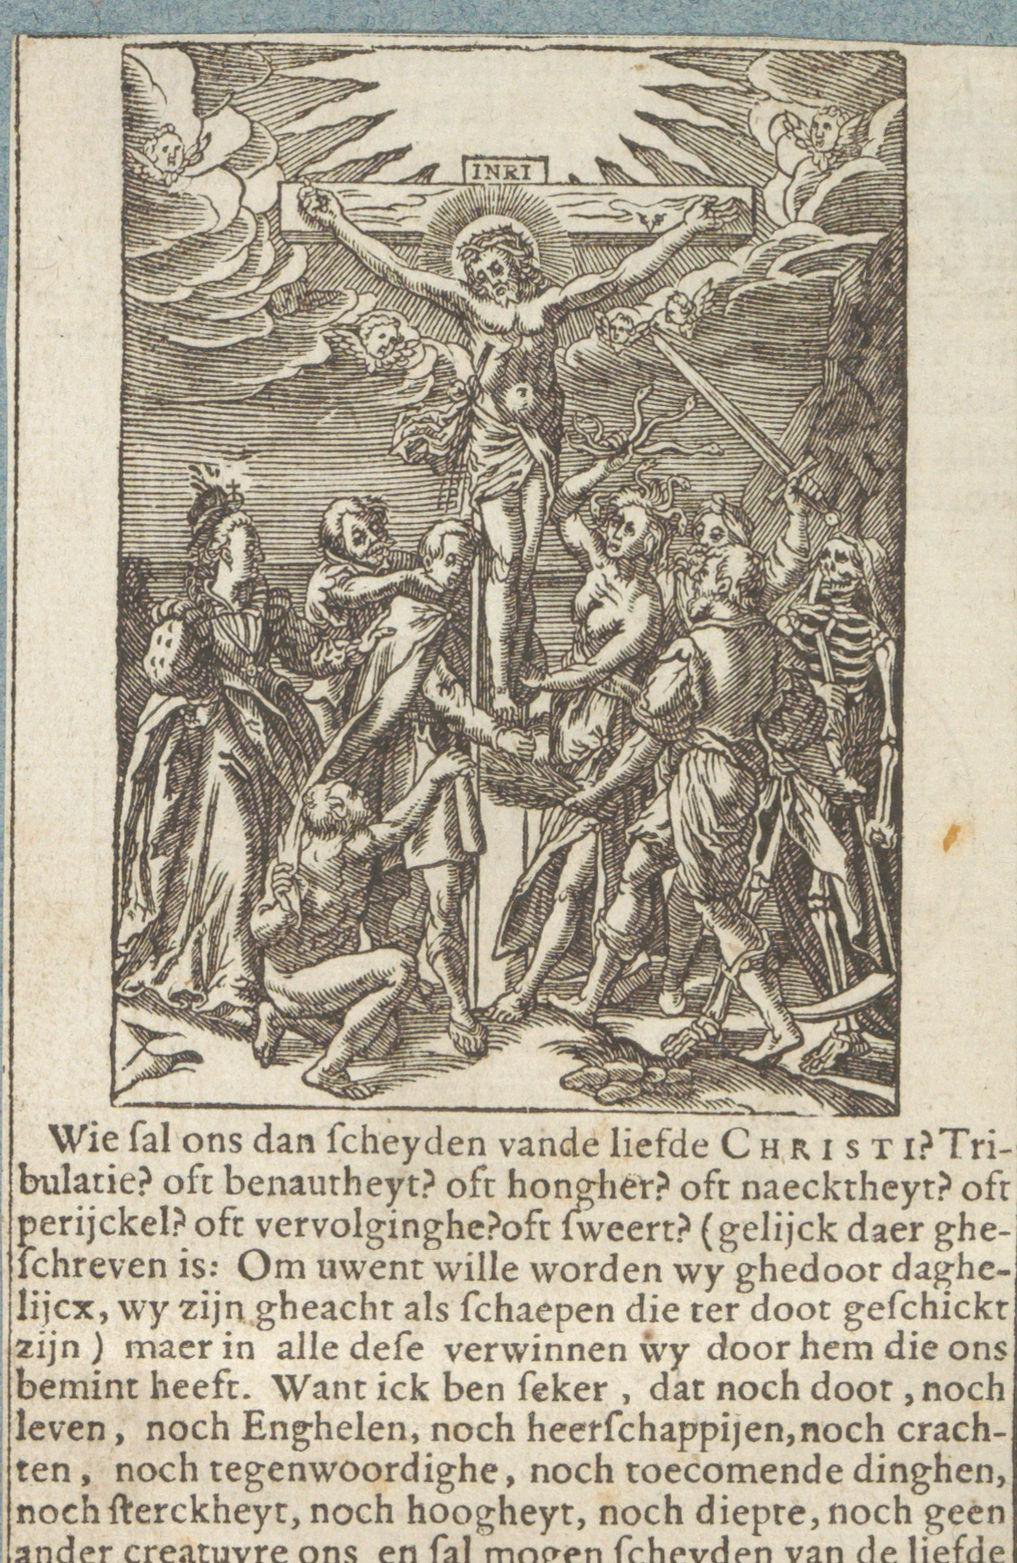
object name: album leaf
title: Christus aan het kruis en de Dood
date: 1629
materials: paper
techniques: letterpress printing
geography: amsterdam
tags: epistle of paul to the romans, crucified christ with other persons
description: Verbeelding van Rom. 8: 35-39: 'Wat zal ons scheiden van de liefde van Christus? Tegenspoed, ellende of vervolging, honger of armoede, gevaar of het zwaard?' Rechts de Dood. Onder de voorstelling de betreffende tekst uit het bijbelboek Romeinen. De prent maakt deel uit van een album.